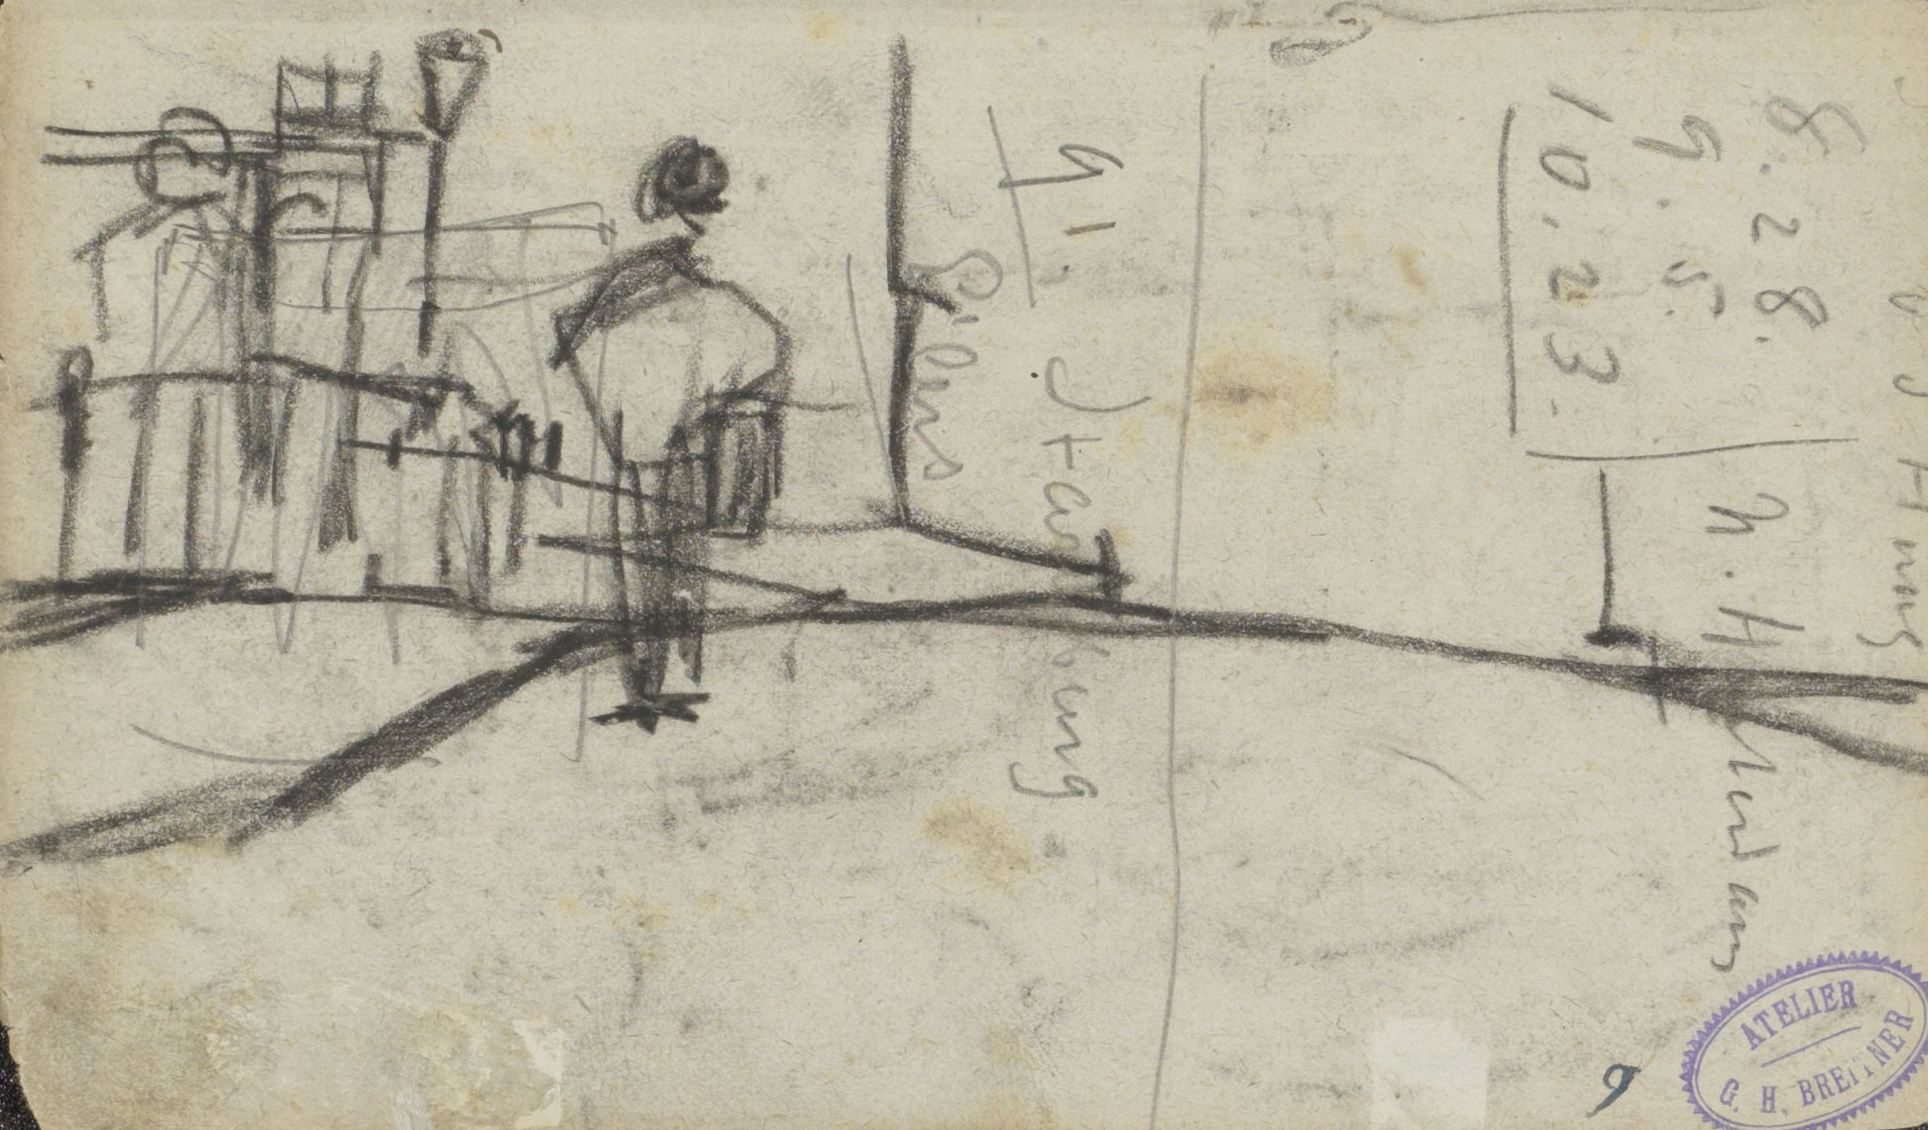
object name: drawing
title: Figuren op een brug in Amsterdam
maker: george hendrik breitner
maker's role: draughtsman, painter, print maker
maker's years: 1857-1923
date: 1886-1923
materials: chalk, paper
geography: amsterdam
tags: bridge in city across river, canal, etc. (+ city(-scape) with figures, staffage), amsterdam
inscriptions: annotation: ‘v d Haag n. Amsterdam [met treintijden?]/ 91 Startburg[?]/ Eilers’, workshop stamp: Lugt 291d